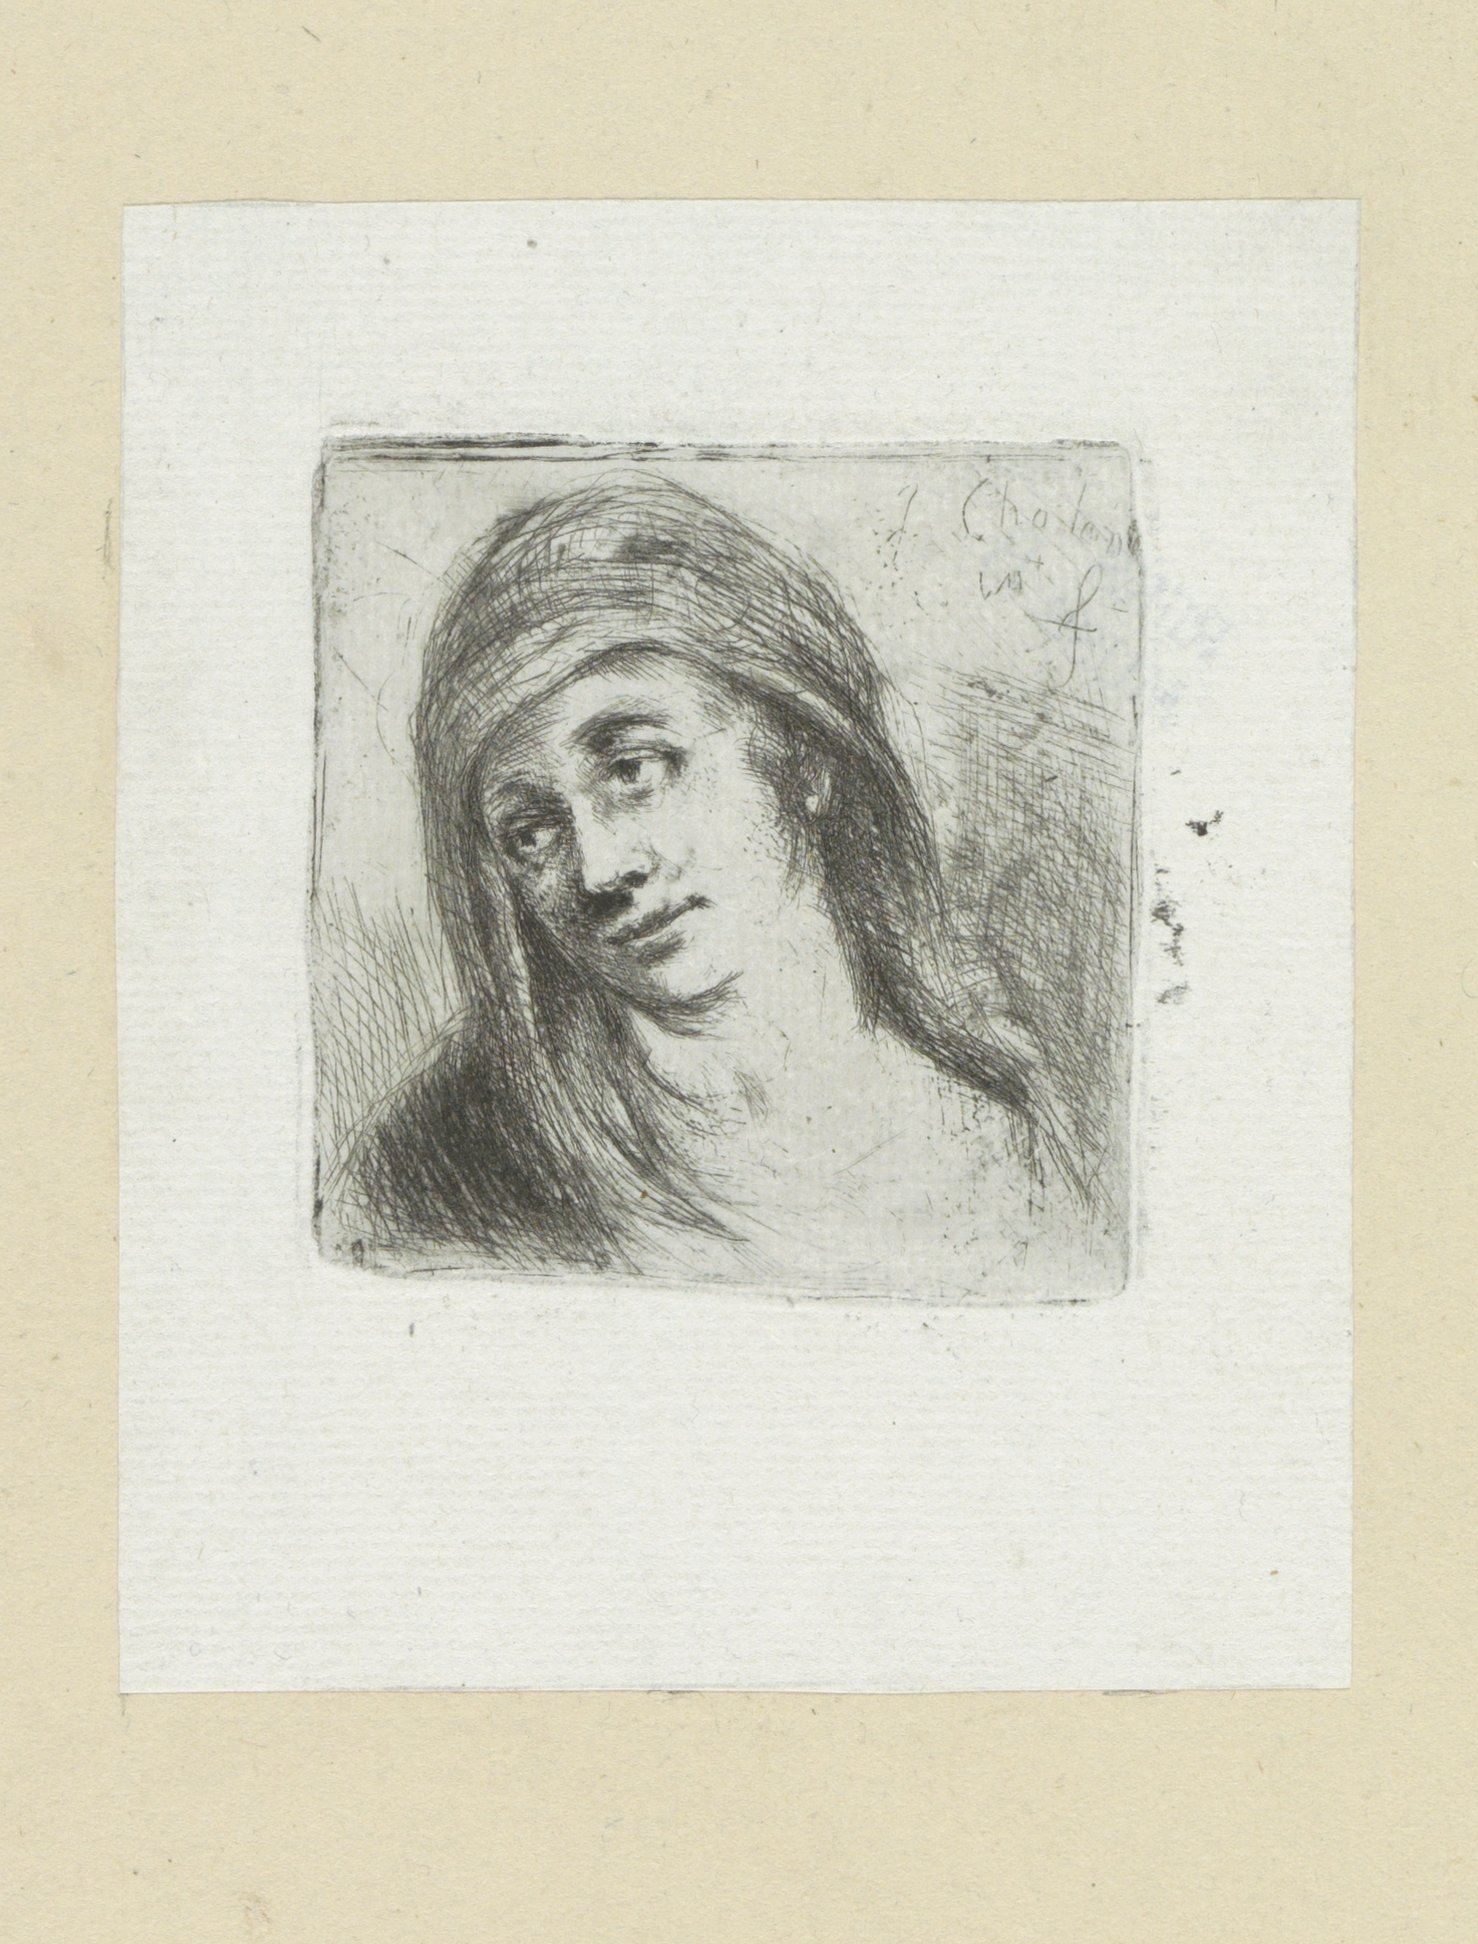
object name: album leaf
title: The Compleat Work of Etchings by John Chalon / Oeuvre Complette des Eaux Fortes par Jean Chalon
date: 1802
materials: paper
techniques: drypoint, etching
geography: london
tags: veil, morphology of human expression (+ adult female (human being))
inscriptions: collector's mark: ‘B’, collector's mark: ‘RIJKS / MUSM’